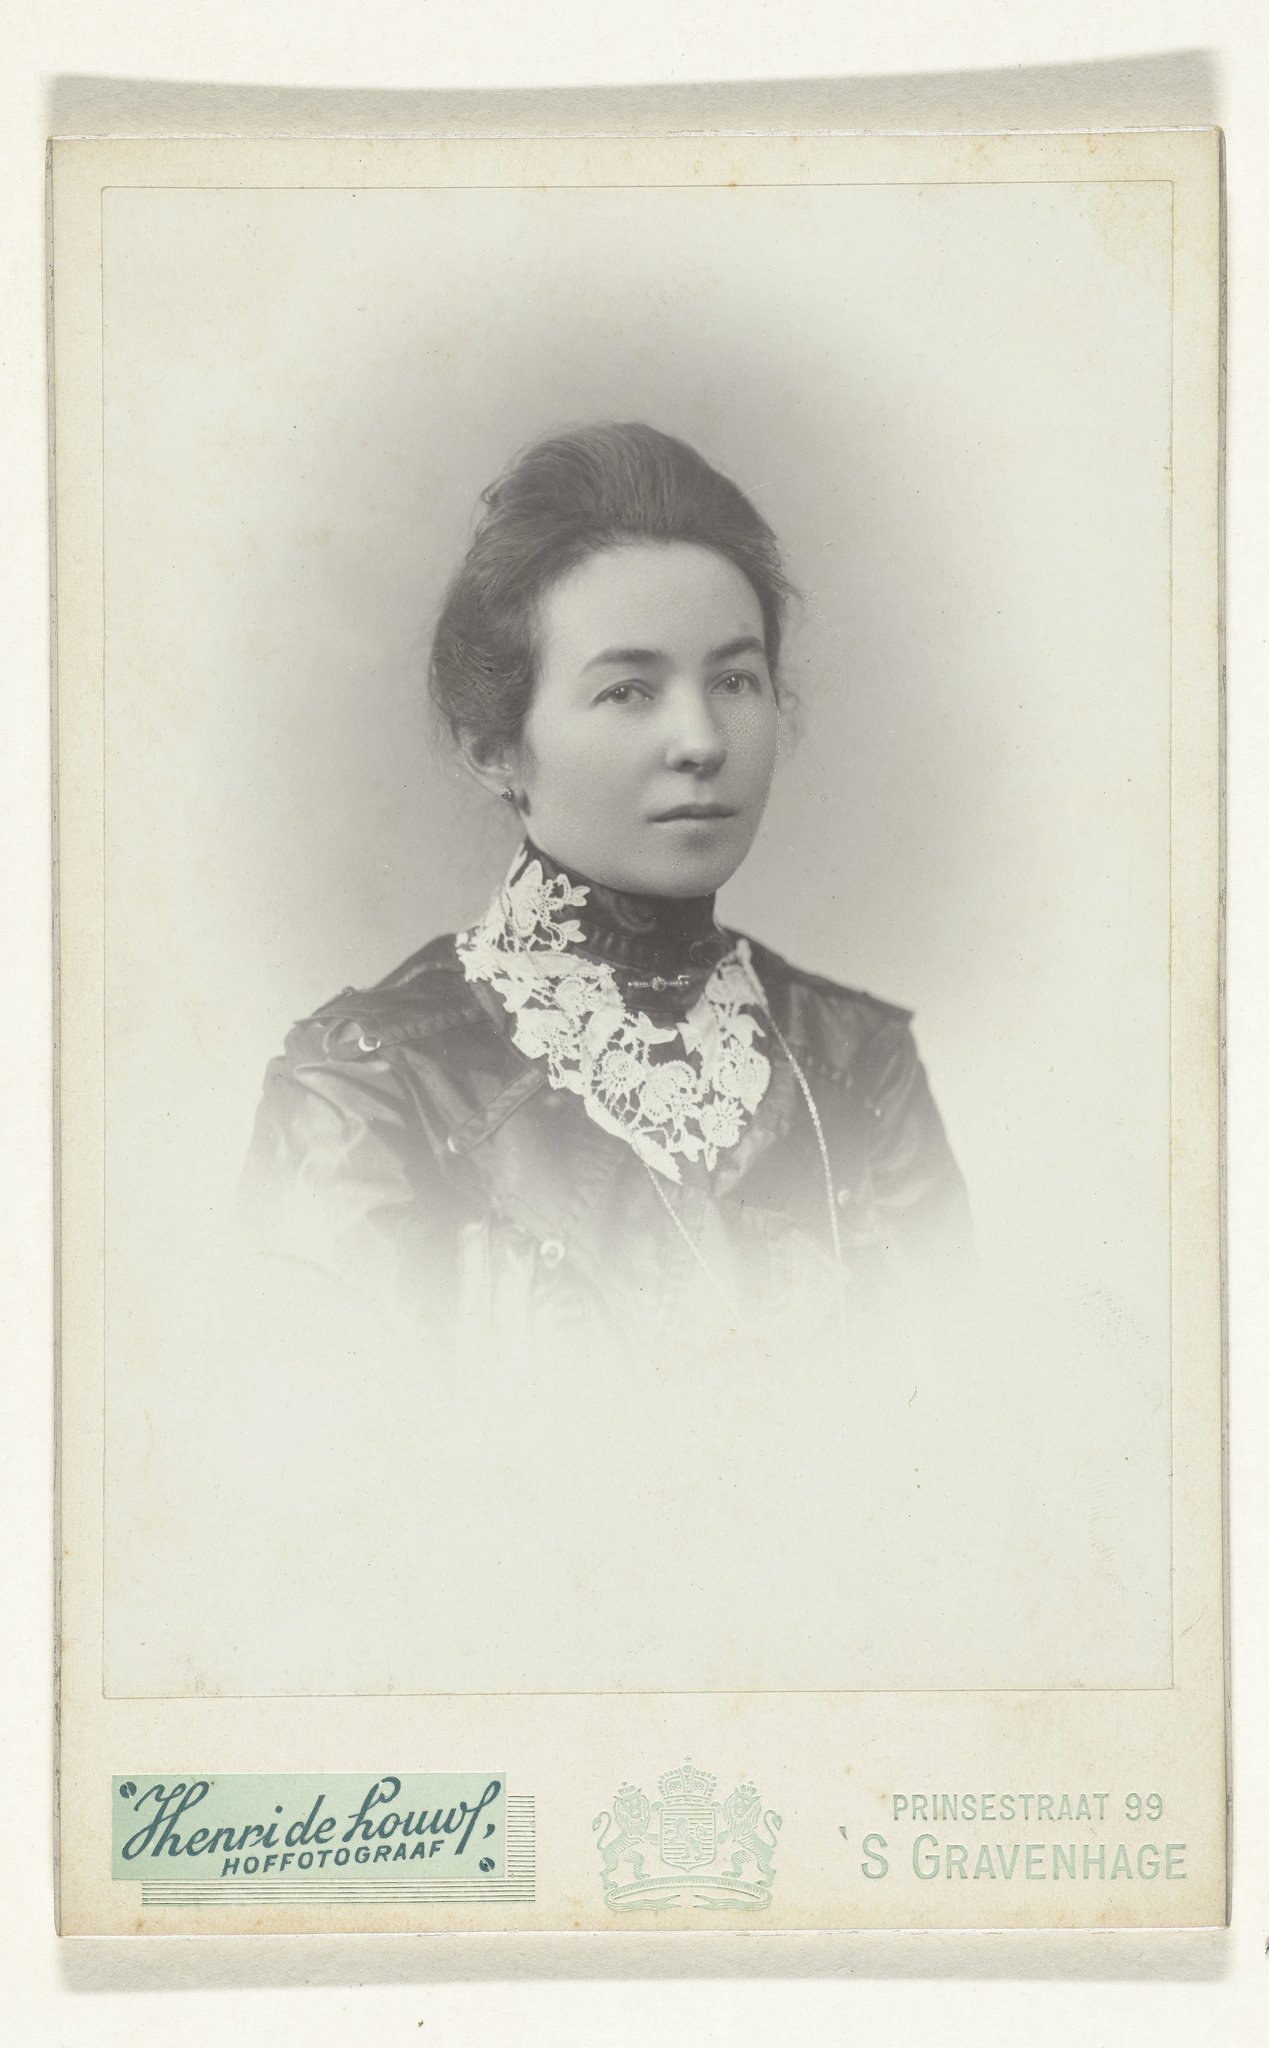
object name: photograph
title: Studioportret van een vrouw in zwarte jurk met wit kanten kraag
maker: henri de louw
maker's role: fotograaf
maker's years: 1851-1944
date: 1890-1915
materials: paper, photographic support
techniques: photography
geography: leiden